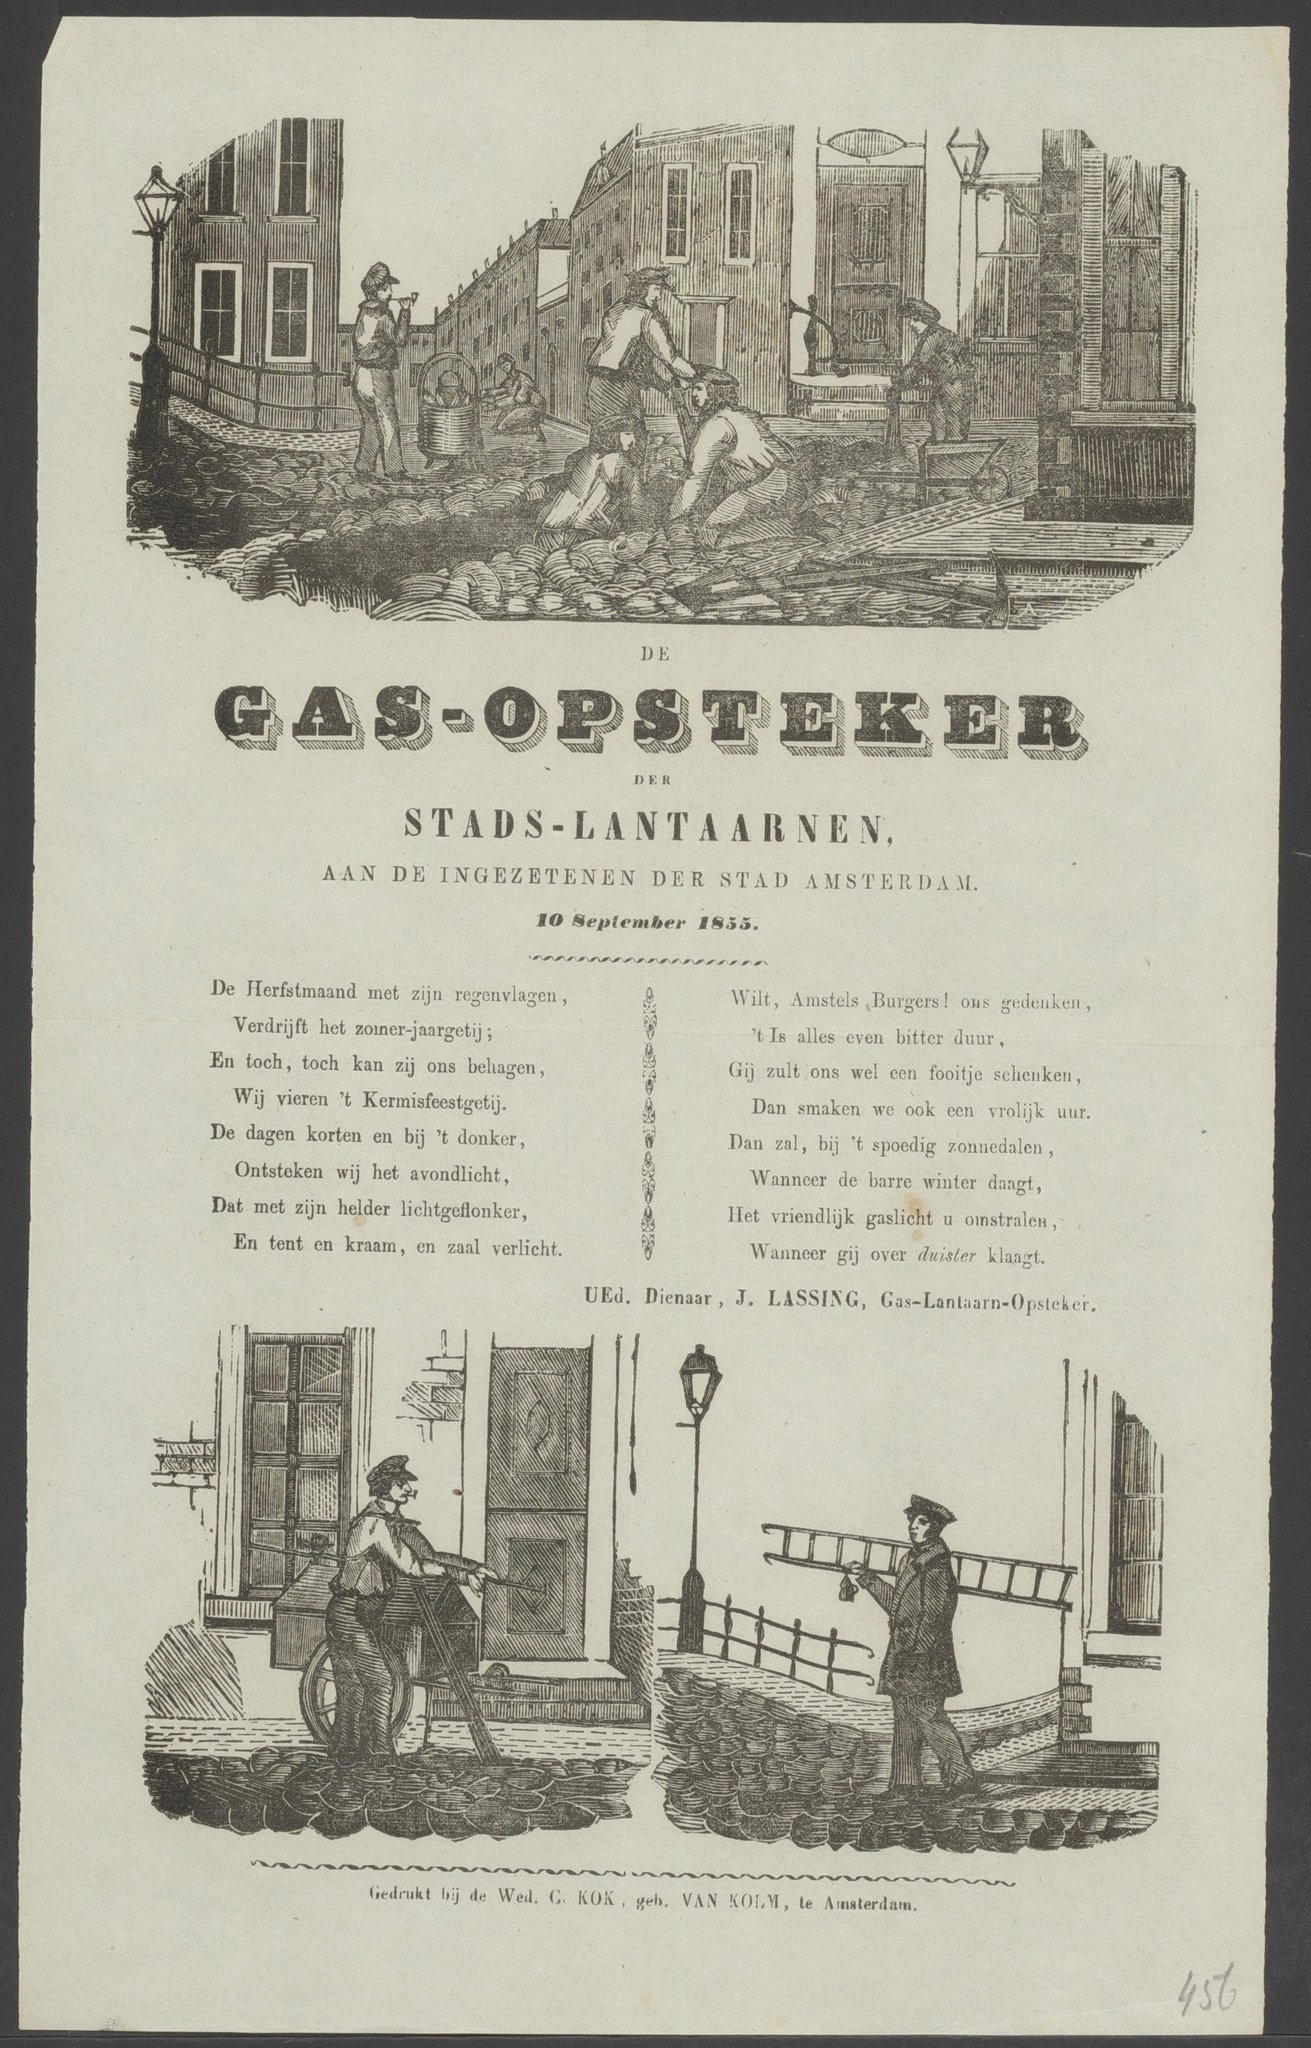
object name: fair print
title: Kermiswens van de gaslantaarnopstekers van Amsterdam voor het jaar 1855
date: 1855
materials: paper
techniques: letterpress printing, engraving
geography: amsterdam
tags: gas-lamp, gas supply, digging (industrial process), street lighting, amsterdam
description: Kermiswens van de Amsterdamse gaslantaarnopstekers voor het jaar 1855. Centraal een vers in twee kolommen. Bovenaan een straat in Amsterdam opgebroken voor de aanleg van de gasleiding. Onderaan twee gasfitters. Van de gaslantaarnopsteker: J. Lassing. Onderwerpsrubrieken binnen de Atlas Zeden en Gewoonten: Zeden en gewoonten in engeren zin, Volksleven, Volksbladen, Nieuwjaars- en Kerstwenschen, Amsterdam.